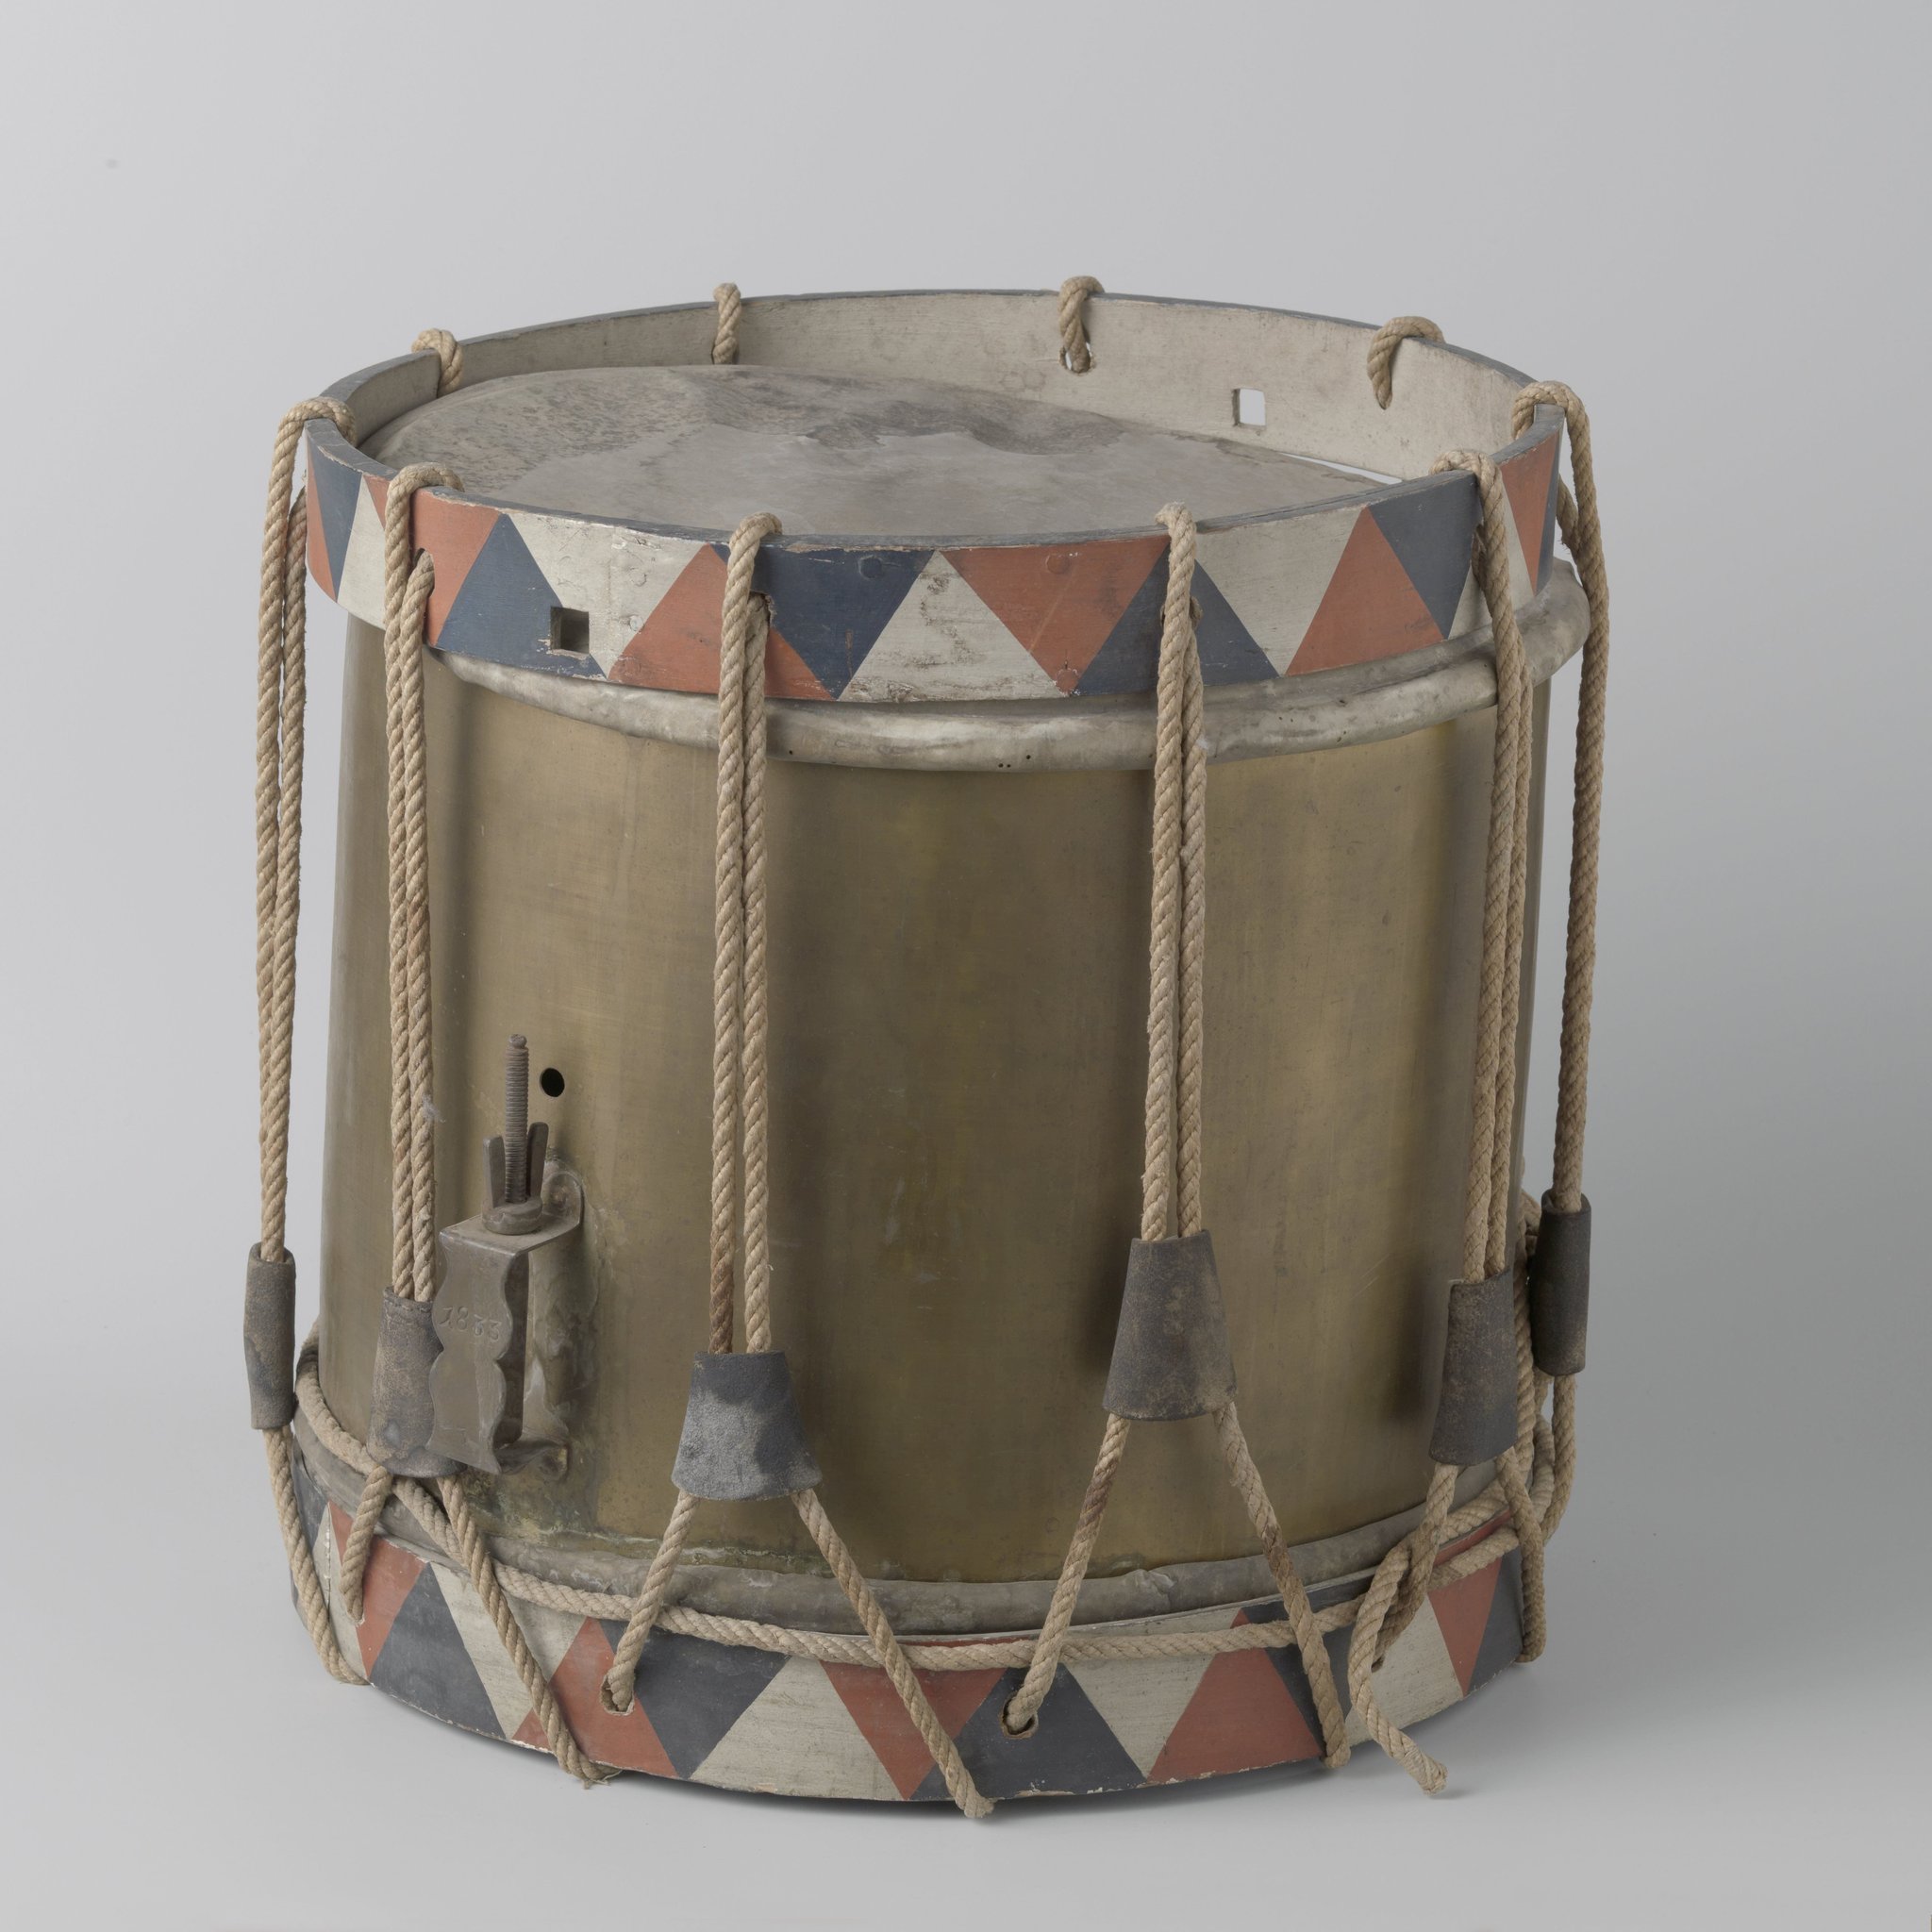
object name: drum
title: Side Drums (39 x)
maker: Anonymous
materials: brass, leather, fiber, wood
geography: netherlands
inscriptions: inscription: ‘1833-1’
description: Music has always been a crucial element of public celebrations, such as military parades, coronations, royal weddings, and funerals, adding grandeur to the solemnity of the occasion. Musical ensembles entrusted with performing music at these events have existed in Europe since the Middle Ages. This display highlights various marching bands and their musical instruments dating from the 16th to the 19th century.